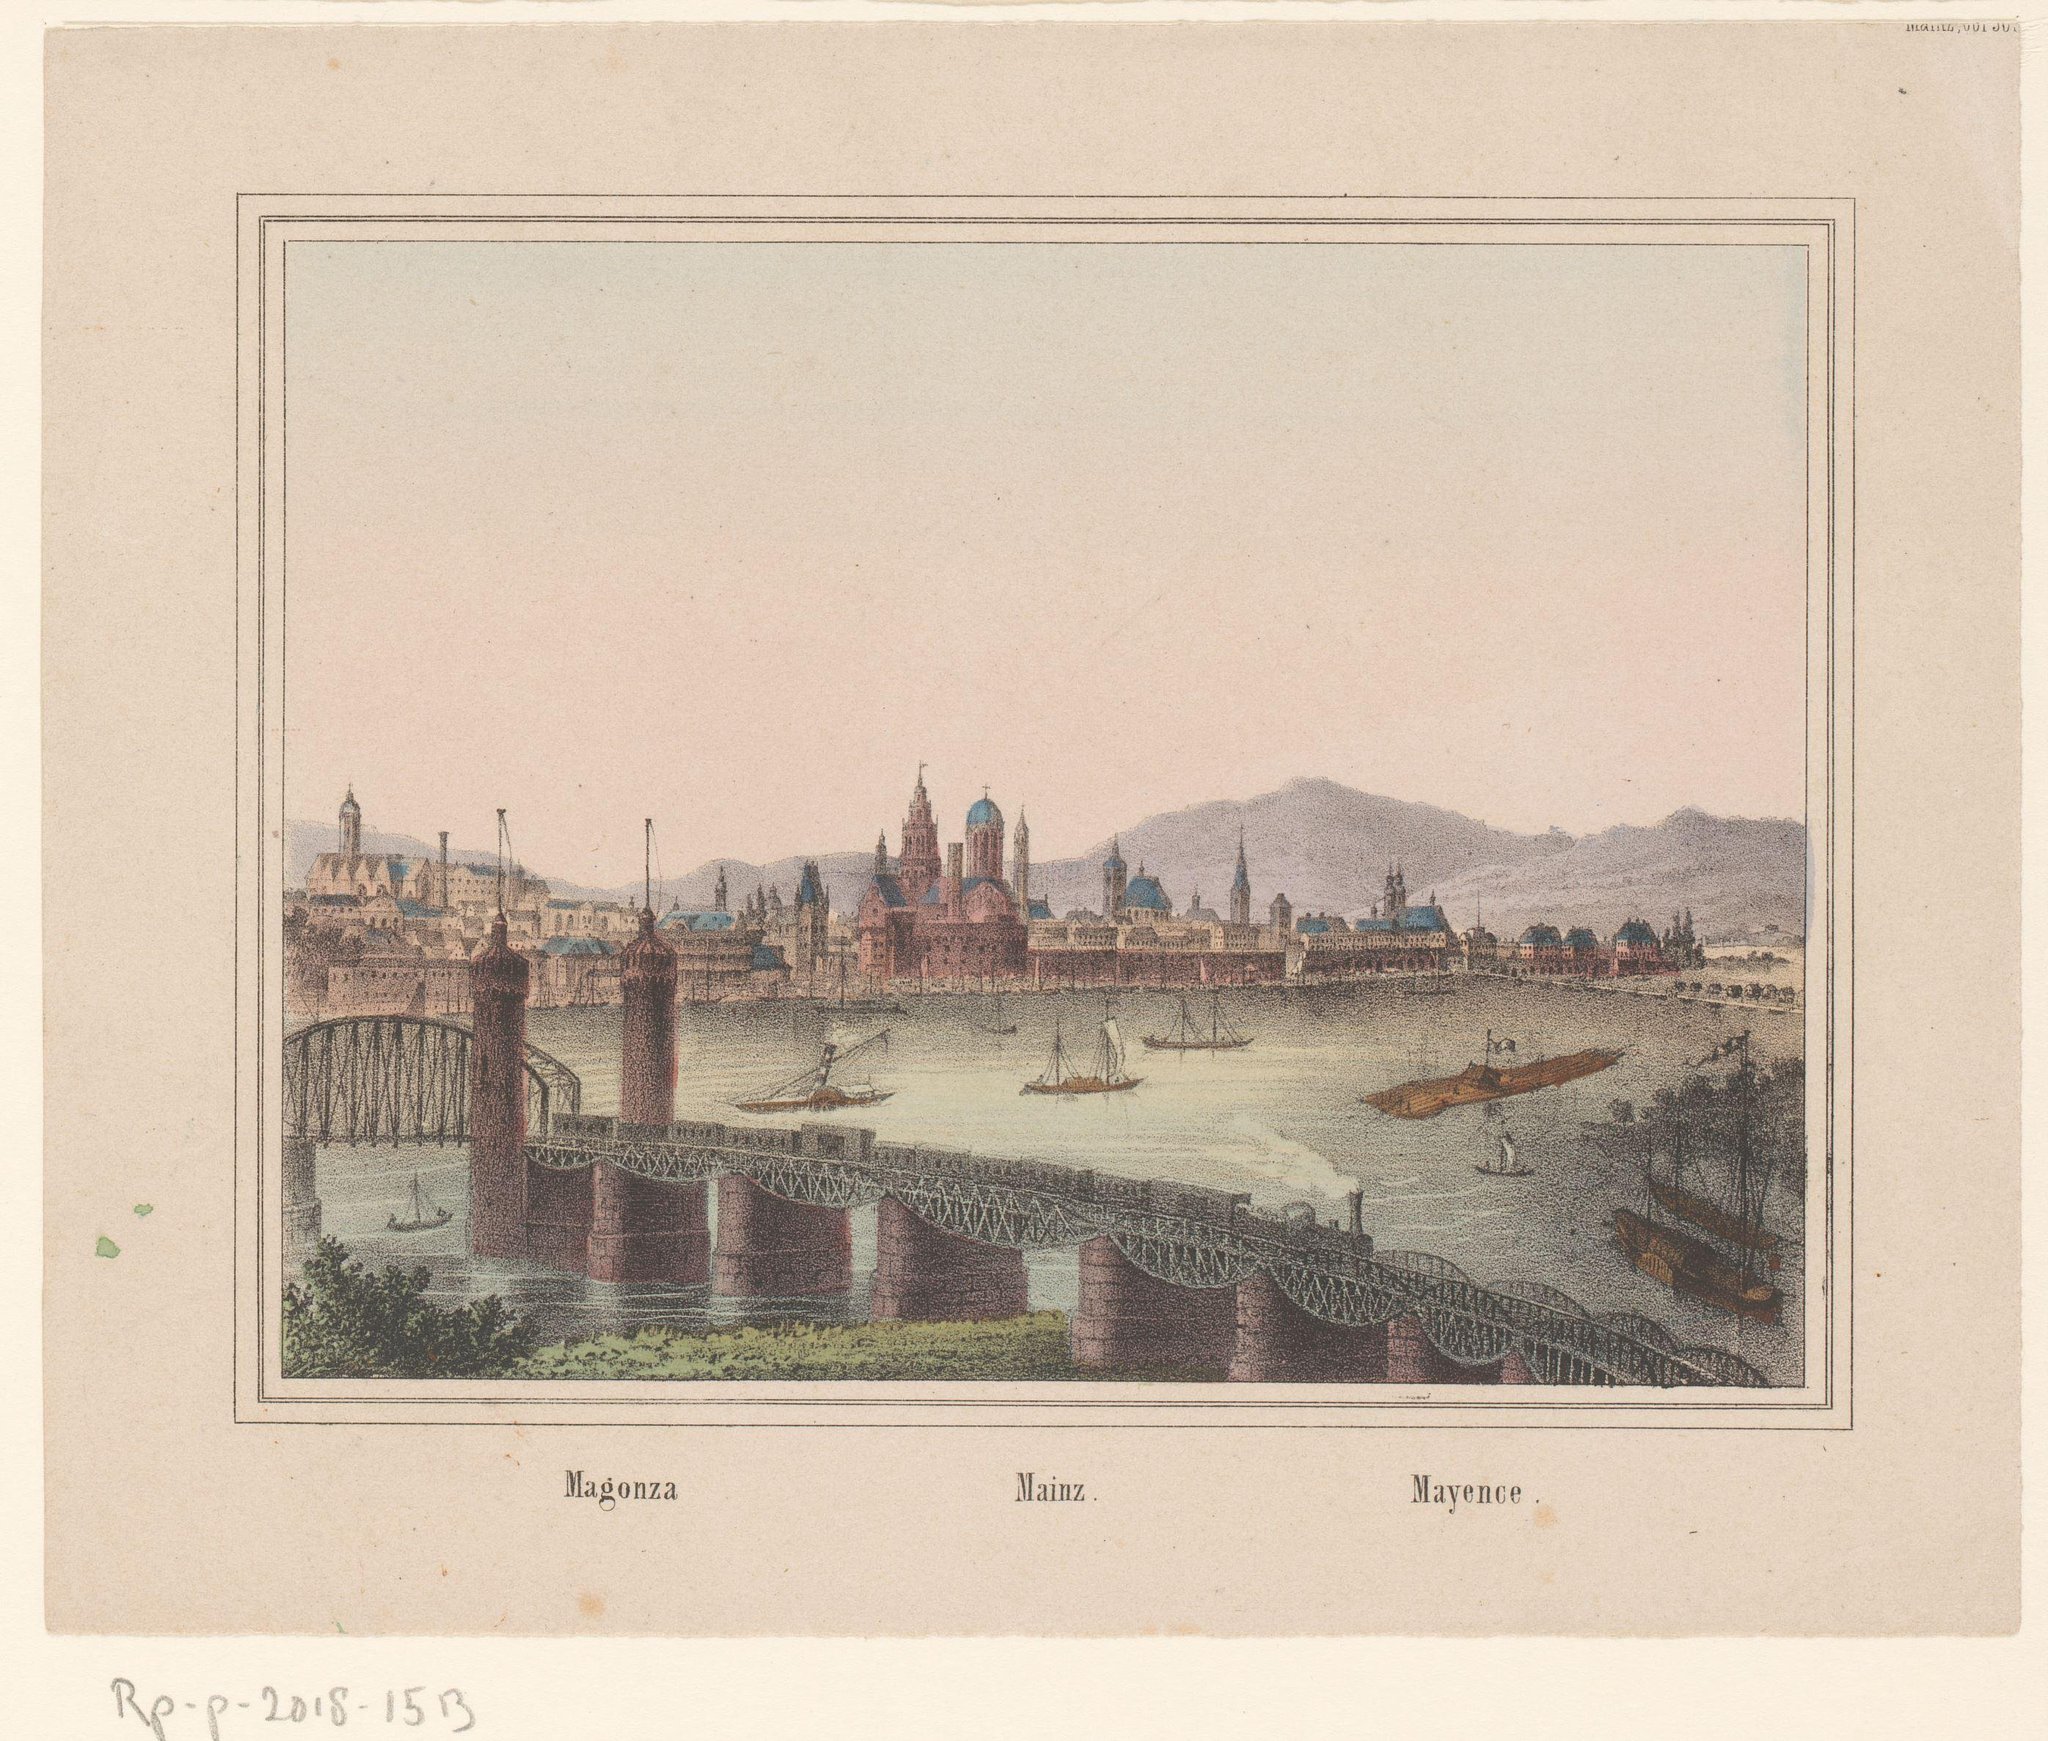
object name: print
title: Magonza / Mainz / Mayence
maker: Anonymous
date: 1800-1899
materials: paper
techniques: lithograph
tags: prospect of city, town panorama, silhouette of city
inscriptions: collector's mark: Lugt 2228